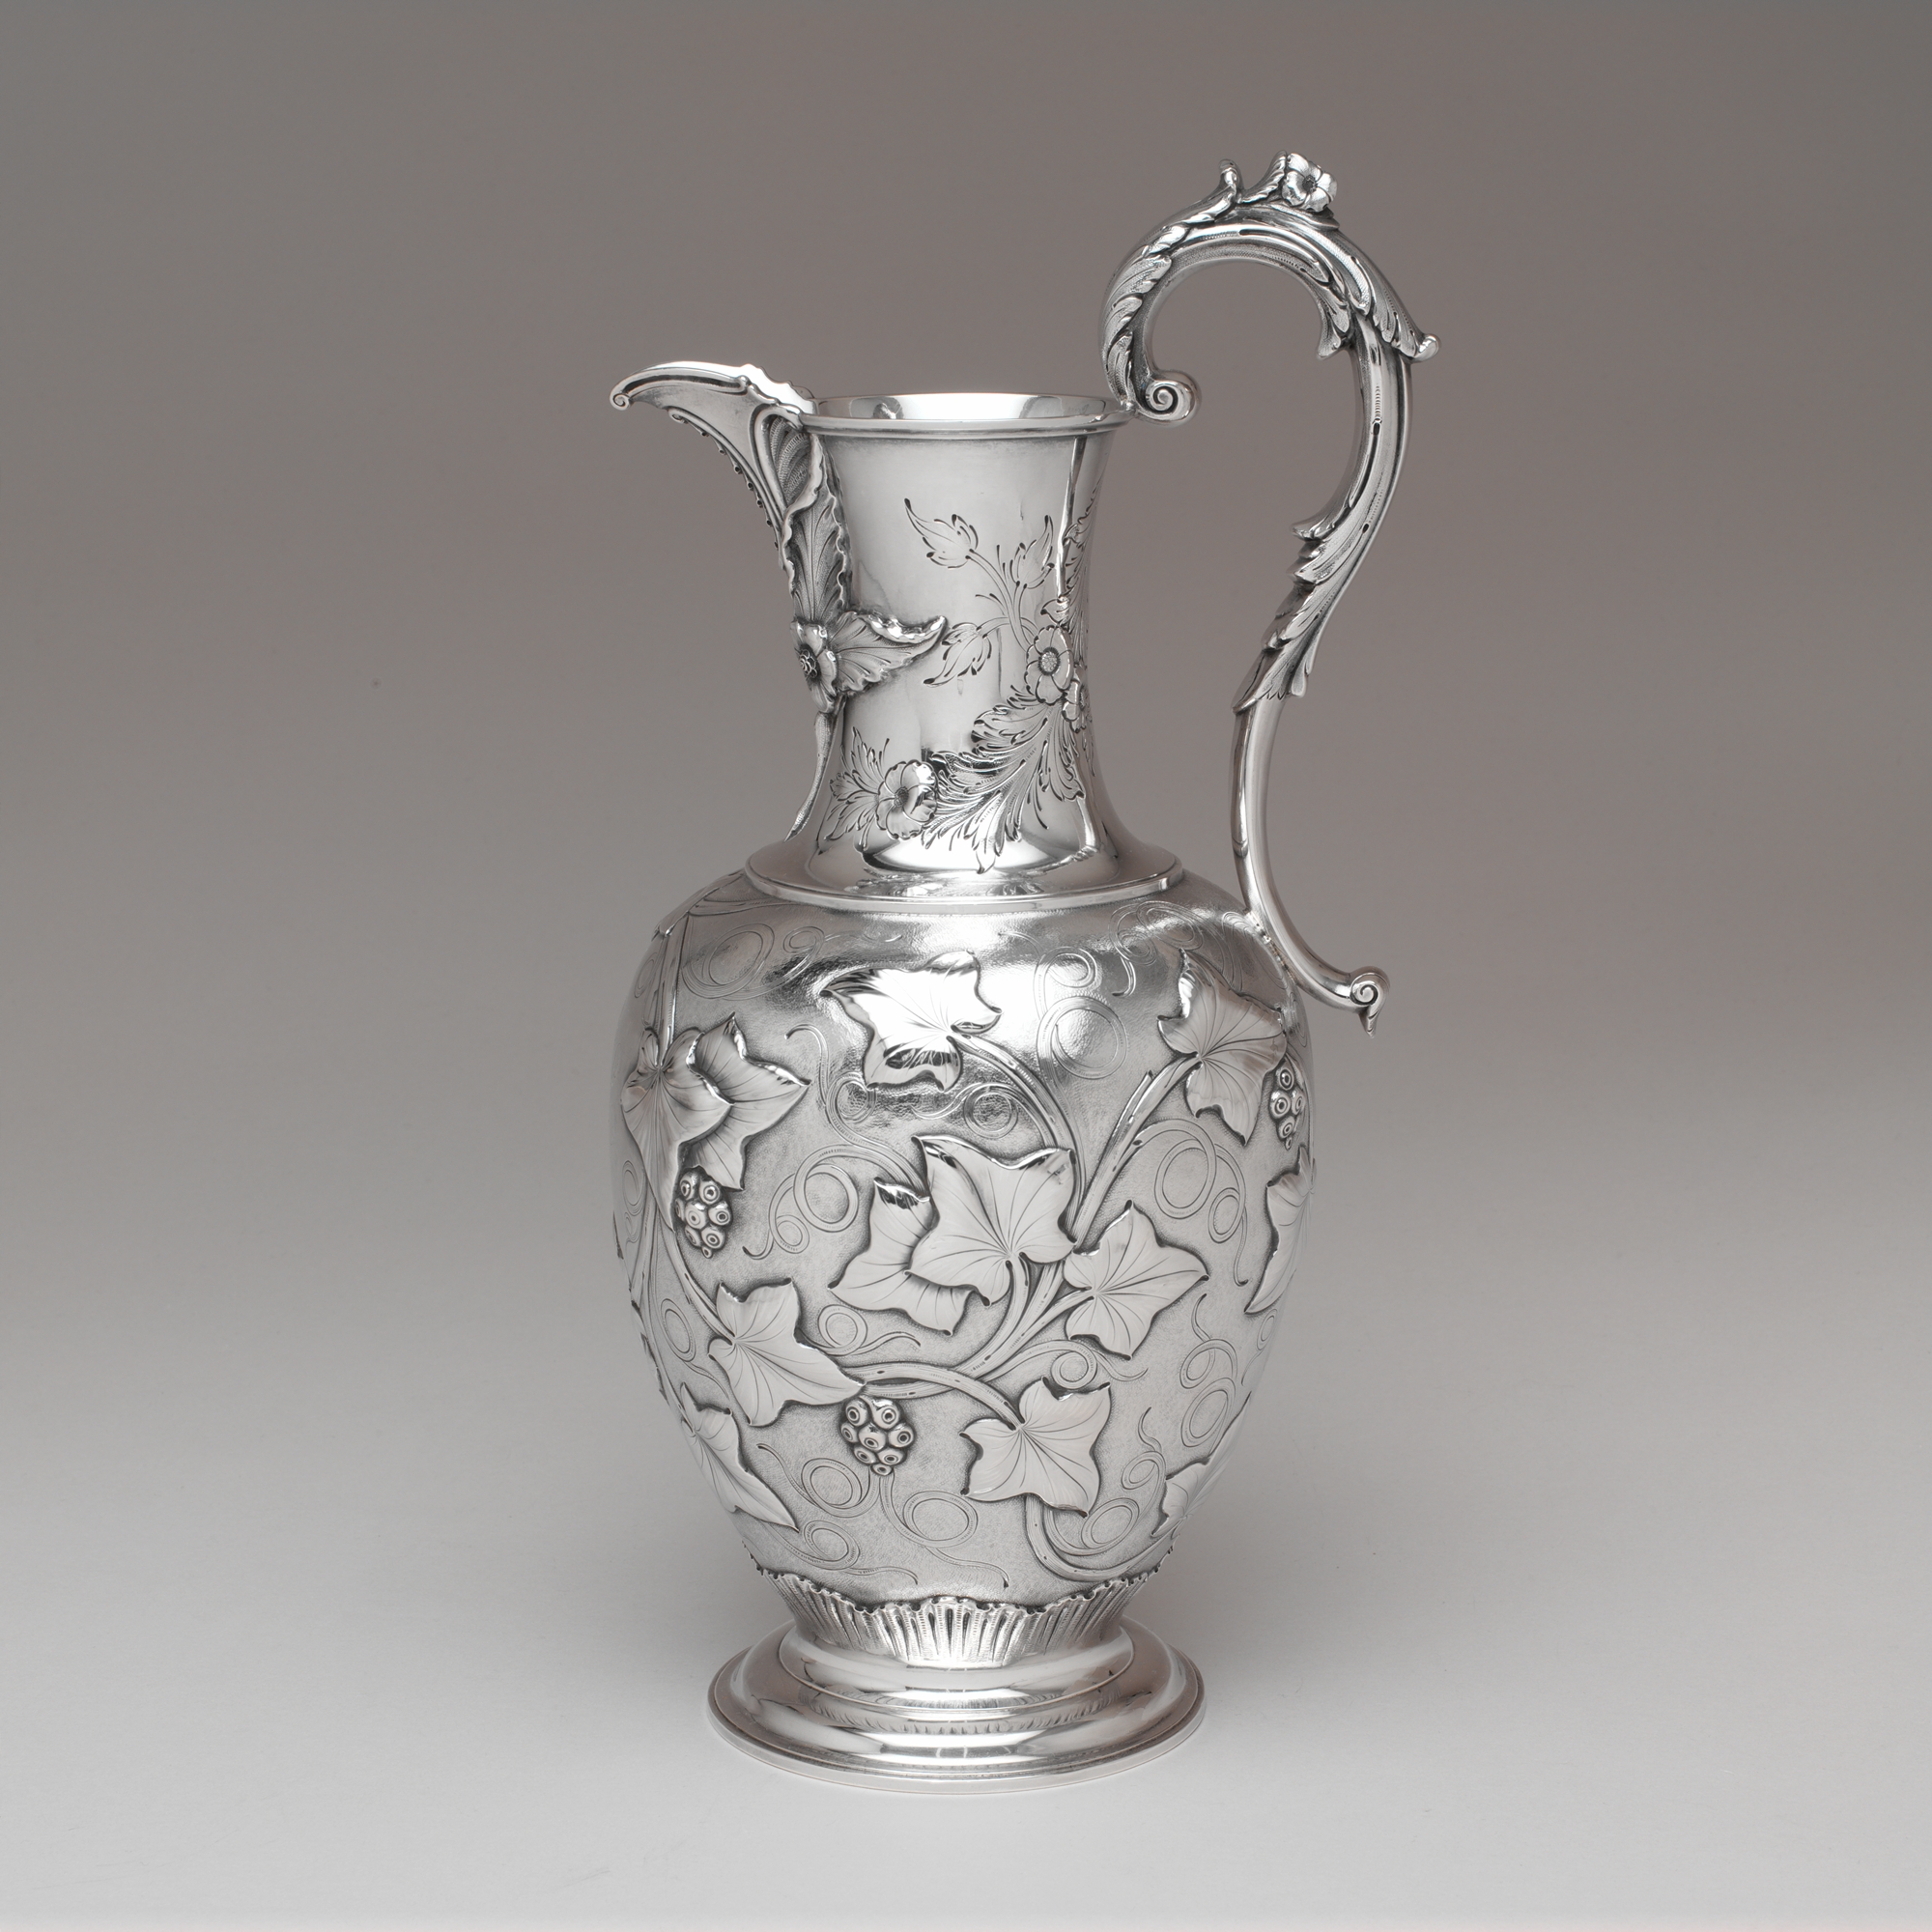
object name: pitcher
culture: american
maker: robert and william wilson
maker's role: maker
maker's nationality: american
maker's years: 1825-1846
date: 1845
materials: silver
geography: united states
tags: grapes,leaves